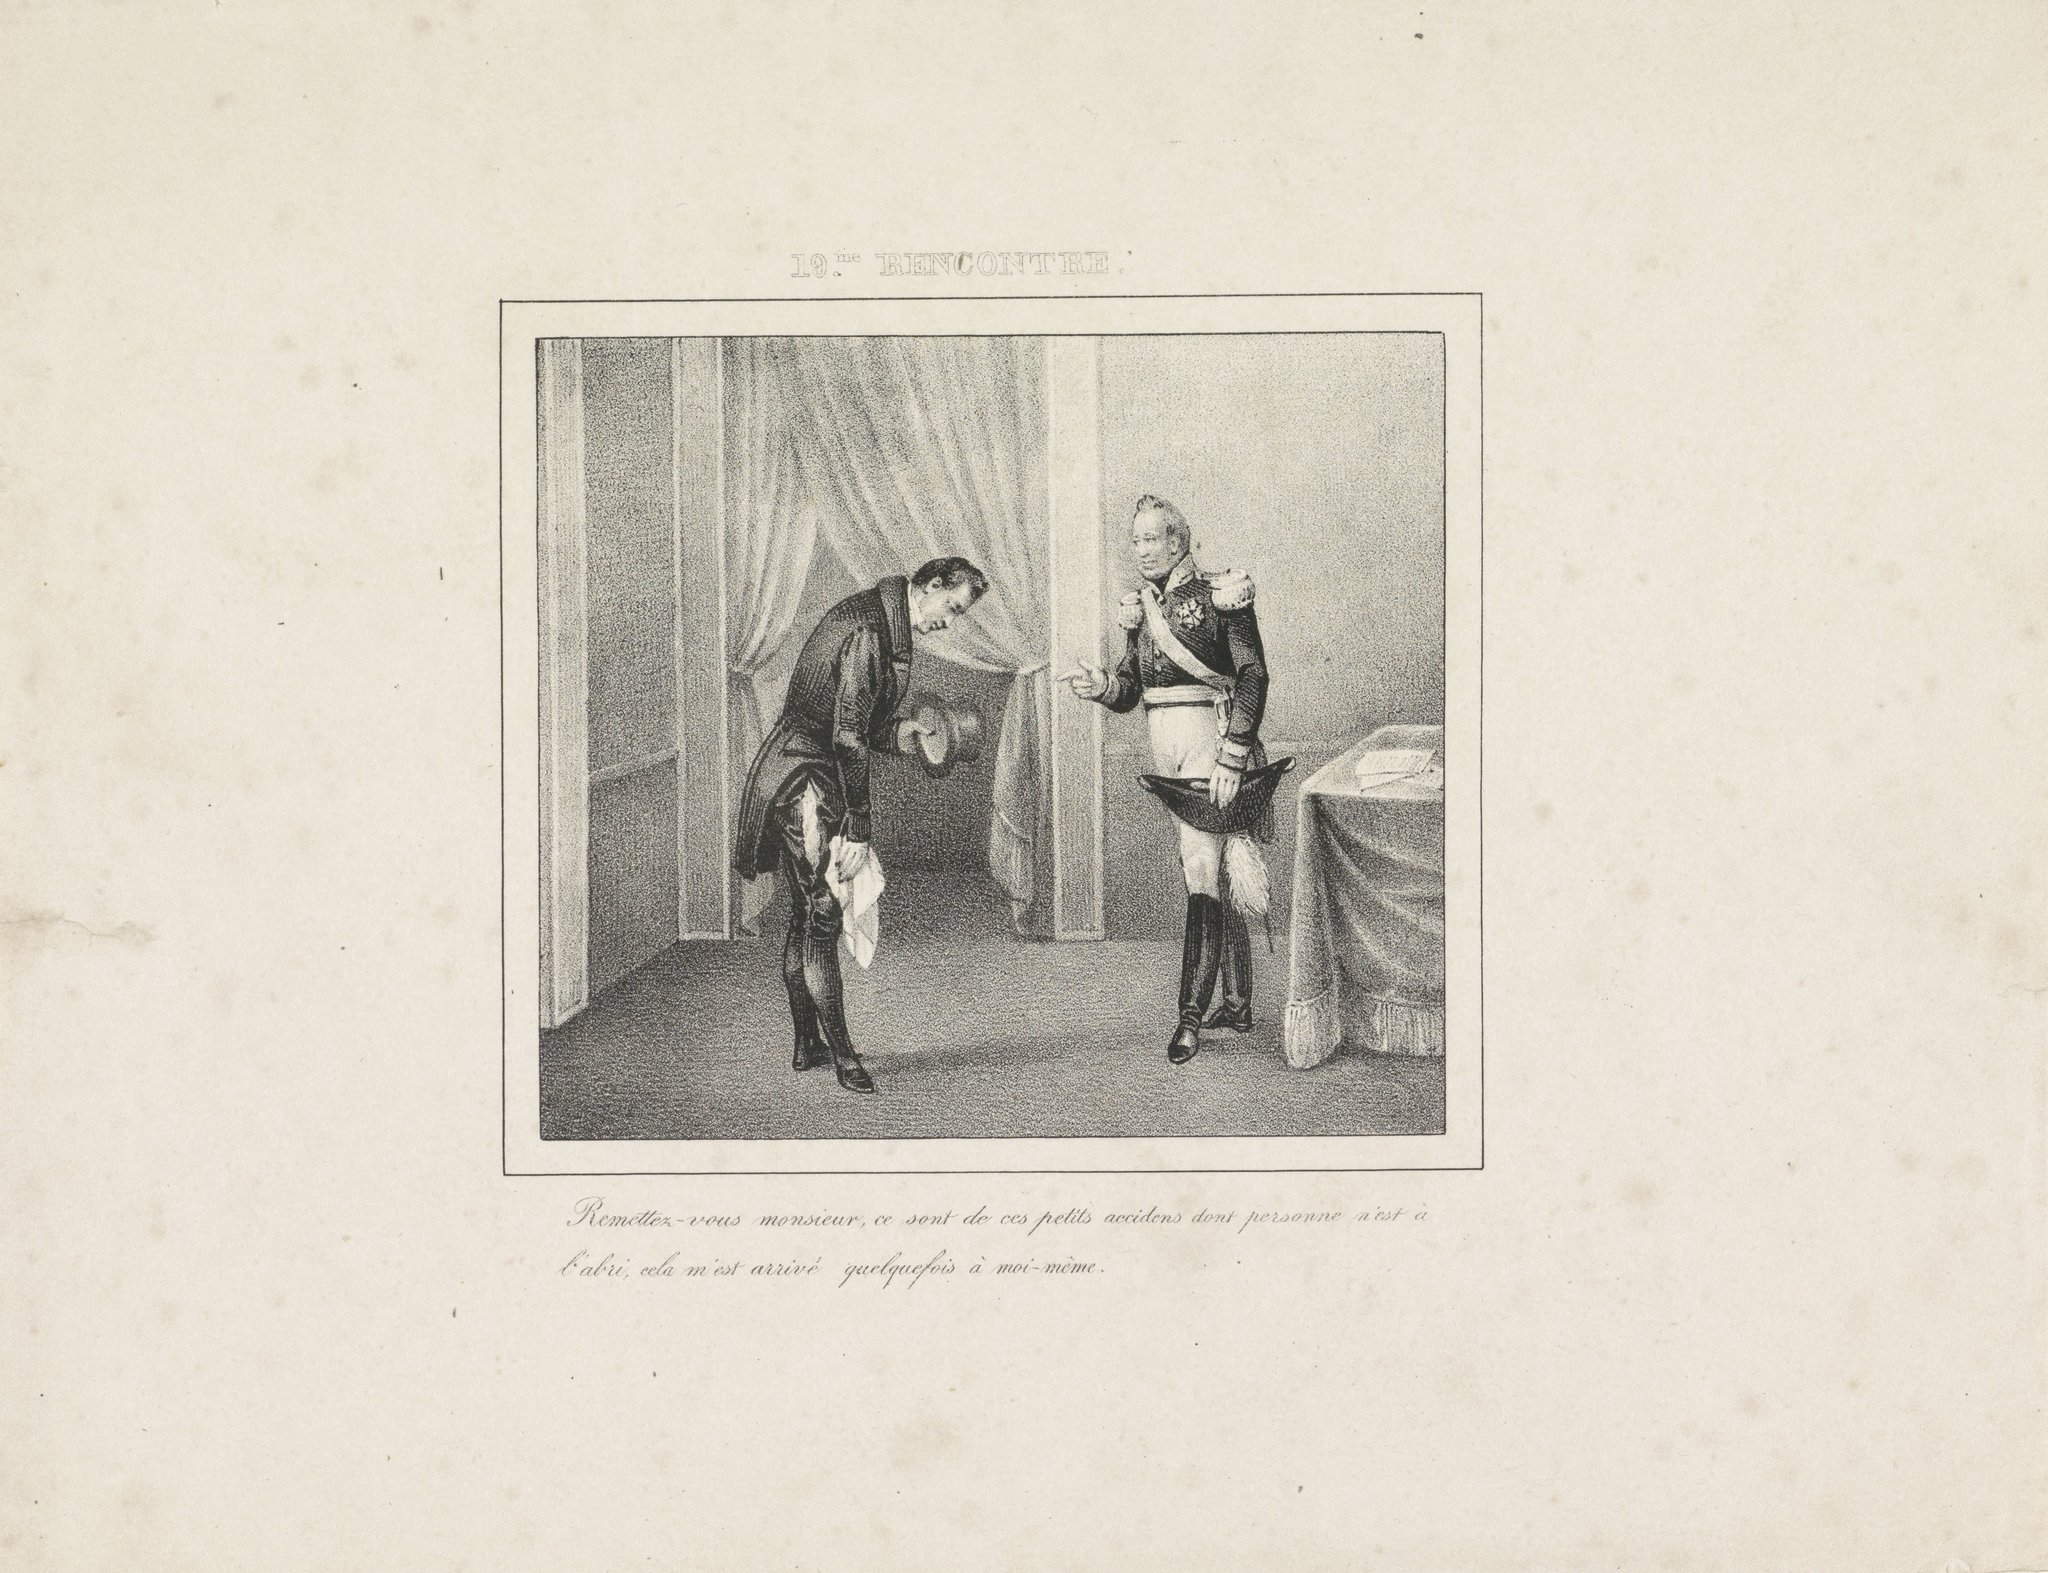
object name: print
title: Ontmoetingen met koning Willem I, 1829-1830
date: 1829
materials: paper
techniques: lithograph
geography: brussels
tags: berlin, william i of the netherlands, ruler in informal contact with his subjects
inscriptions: collector's mark: Lugt 2228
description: De koning stelt een man aan wie hij gehoor verleende, gerust als deze merkt dat zijn broek gescheurd is. Met tweeregelig onderschrift. Onderdeel van de serie van 24 platen met ontmoetingen met koning Willem I, verschenen onder de titel 'Les rencontres' in 1829-1830.